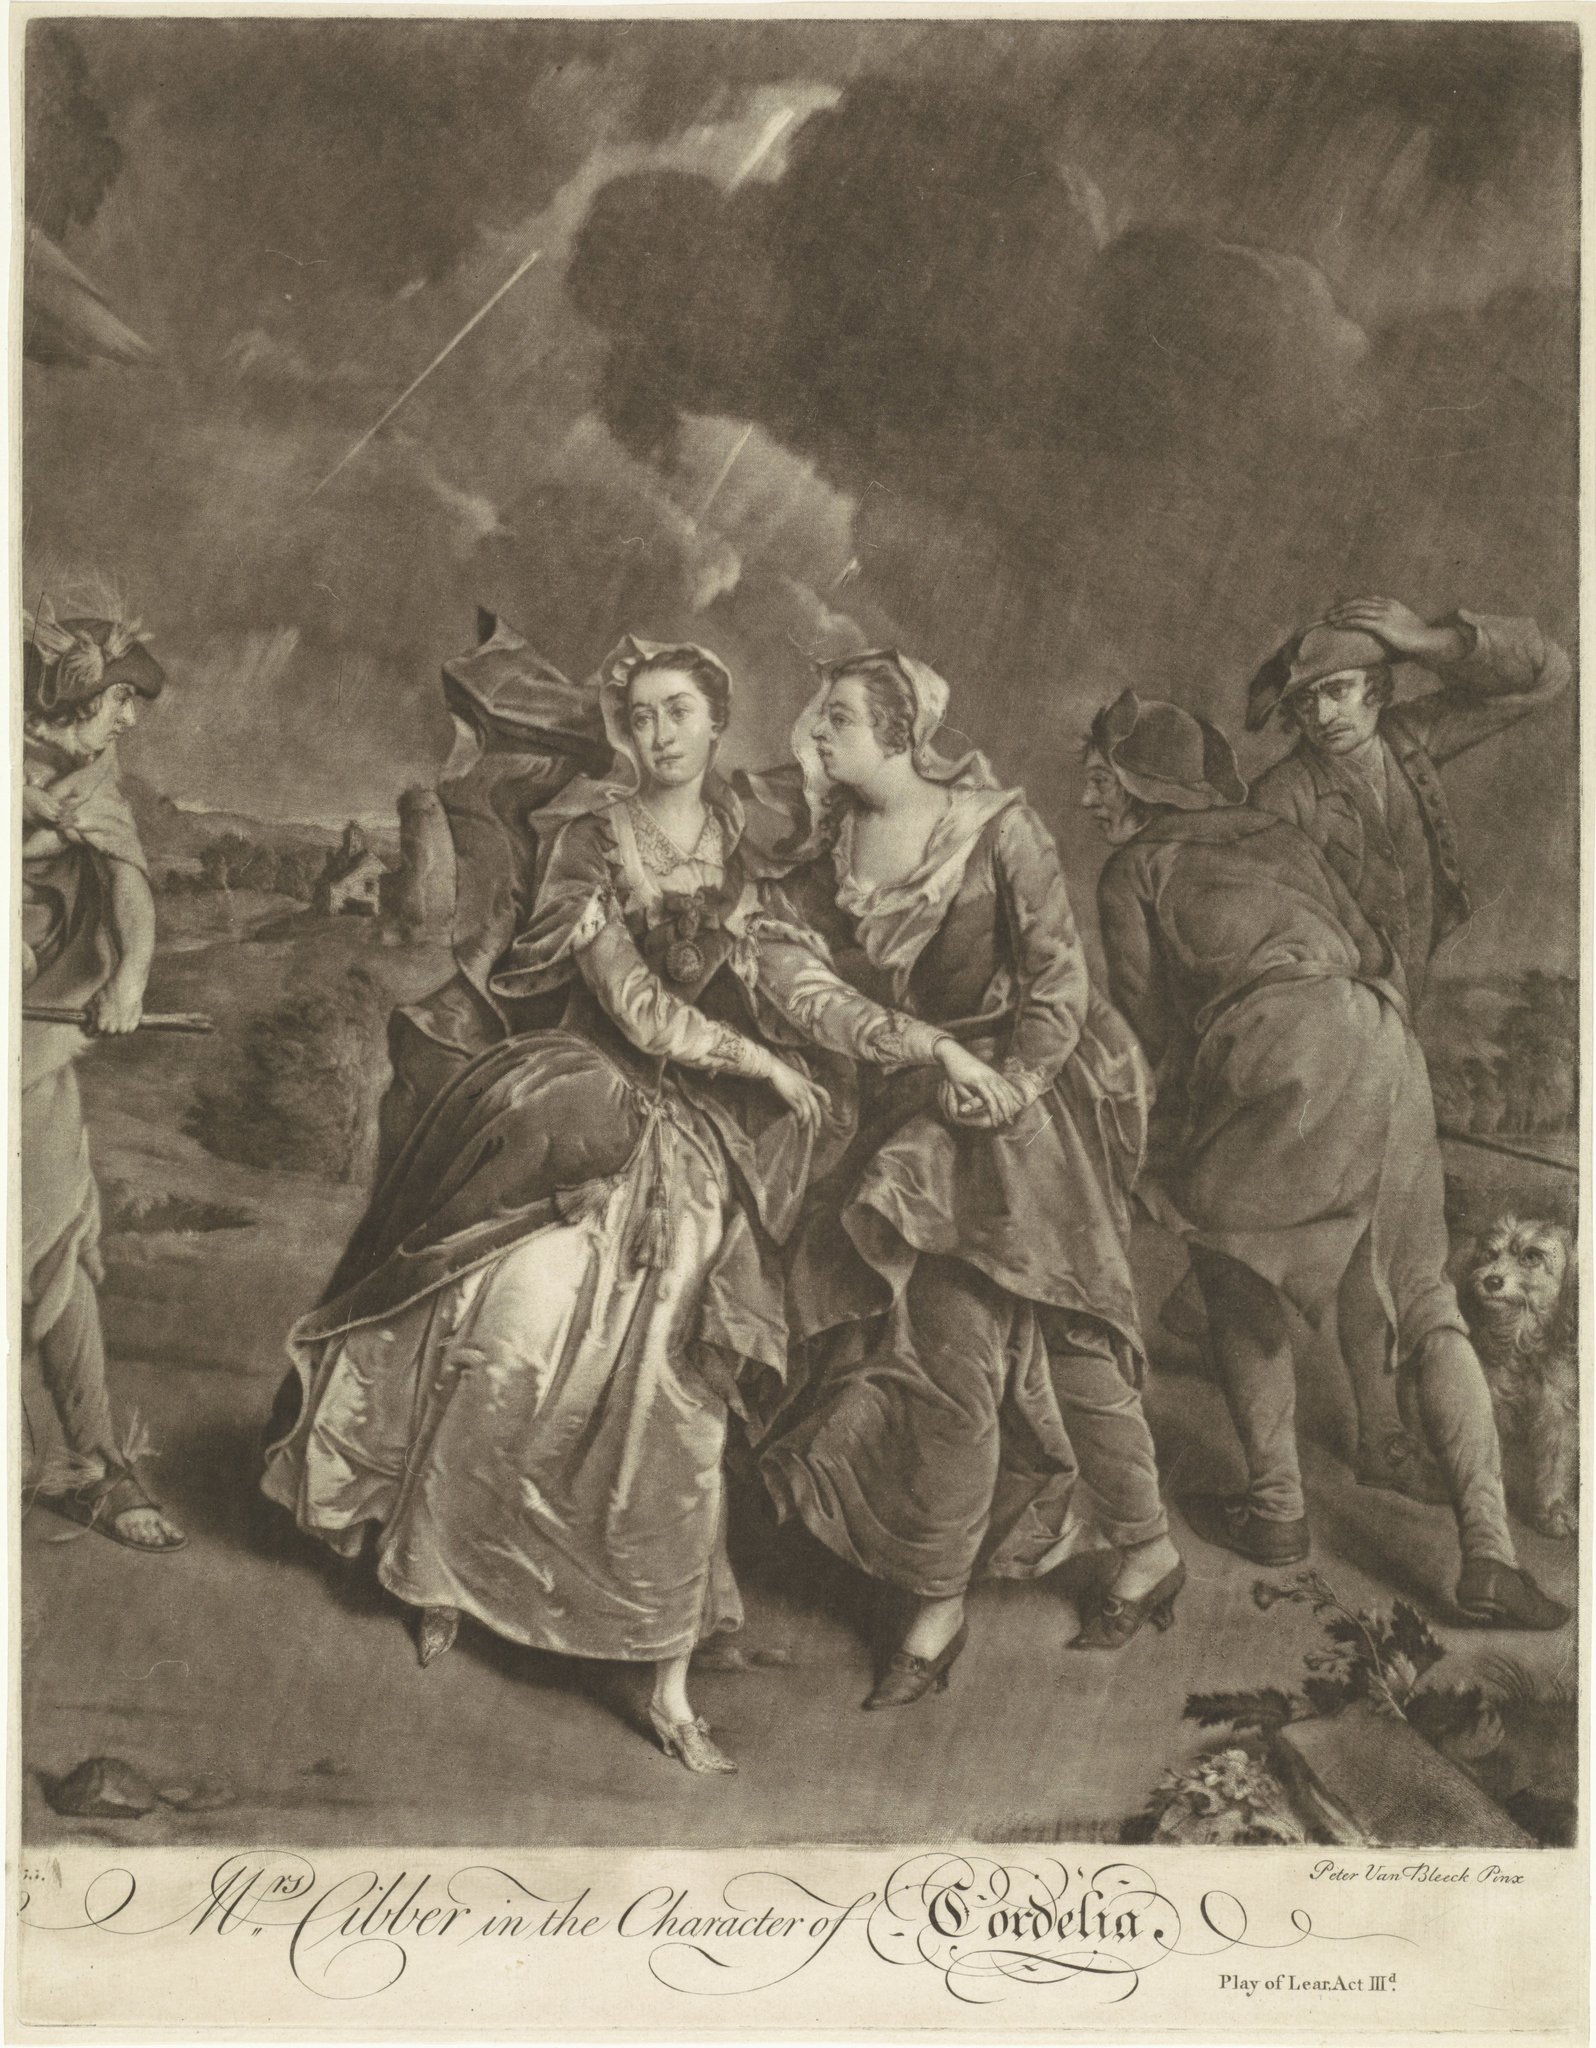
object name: print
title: Actrice Susannah Maria Cibber in de rol van Cordelia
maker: pieter van bleeck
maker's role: print maker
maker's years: 1700-1764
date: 1755-1764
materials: paper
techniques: mezzotint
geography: england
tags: london, group of actors, troupe; actors on the stage, actress (on the stage), king lear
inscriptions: collector's mark: Lugt 240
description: Scène uit Shakespeares King Lear. Cordelia (actrice Susannah Maria Cibber) staat buiten in de storm. Naast haar een vrouw die haar begeleidt. Achter hen drie mannen en een hond. Een van de mannen heeft stro in zijn hoed en in zijn schoenen.